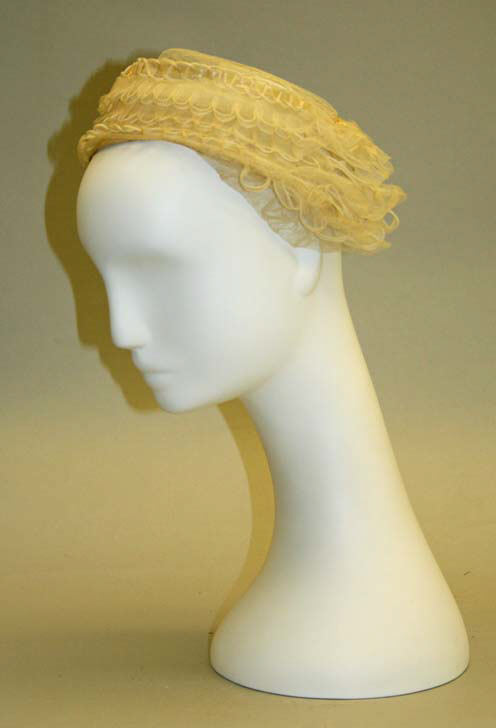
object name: cap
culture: american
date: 1810